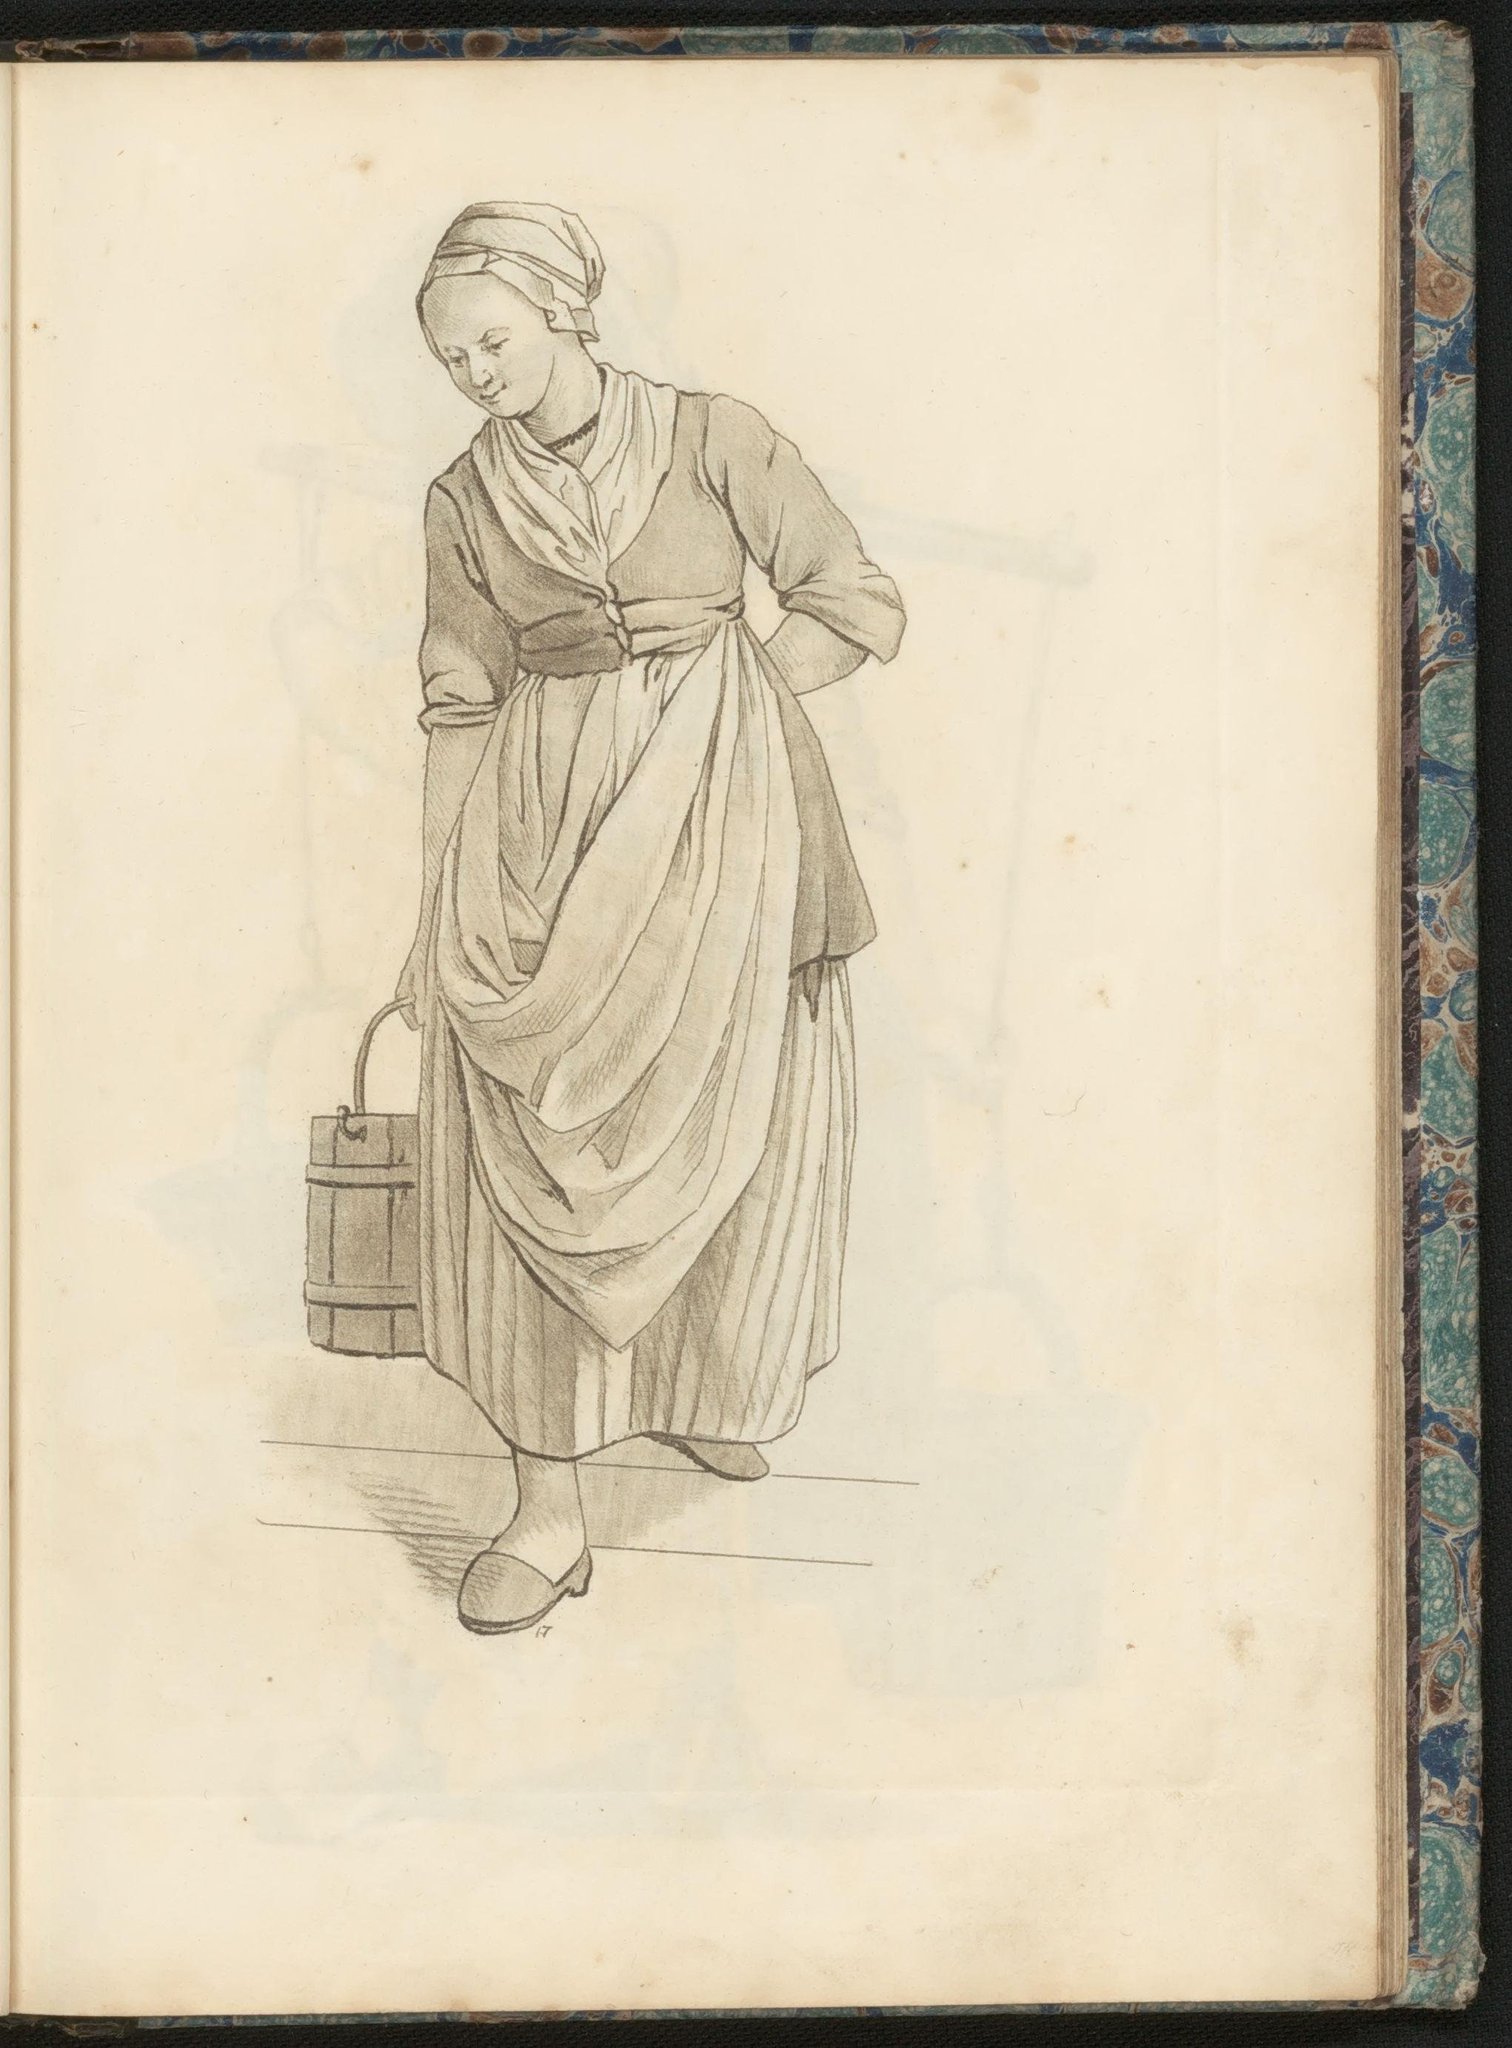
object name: print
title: Vrouw met melkemmer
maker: mathias de sallieth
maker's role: print maker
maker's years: 1749-1791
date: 1772-1791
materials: paper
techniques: printmaking, etching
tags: milkmaid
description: De prent verscheen vanaf 1818 tevens als onderdeel van een 33-delige reeks prenten door Mathias de Sallieth, samengebonden in: Perkois, Jacobus, Prins, Johannes Huibert. Verzameling van verschillende gekleede mans- en vrouwenstanden, ter oefening van jonge schilders en liefhebbers. Rotterdam: Johannes Immerzeel, 1818. Alle verso-bladen uit dit prentalbum zijn blanco.